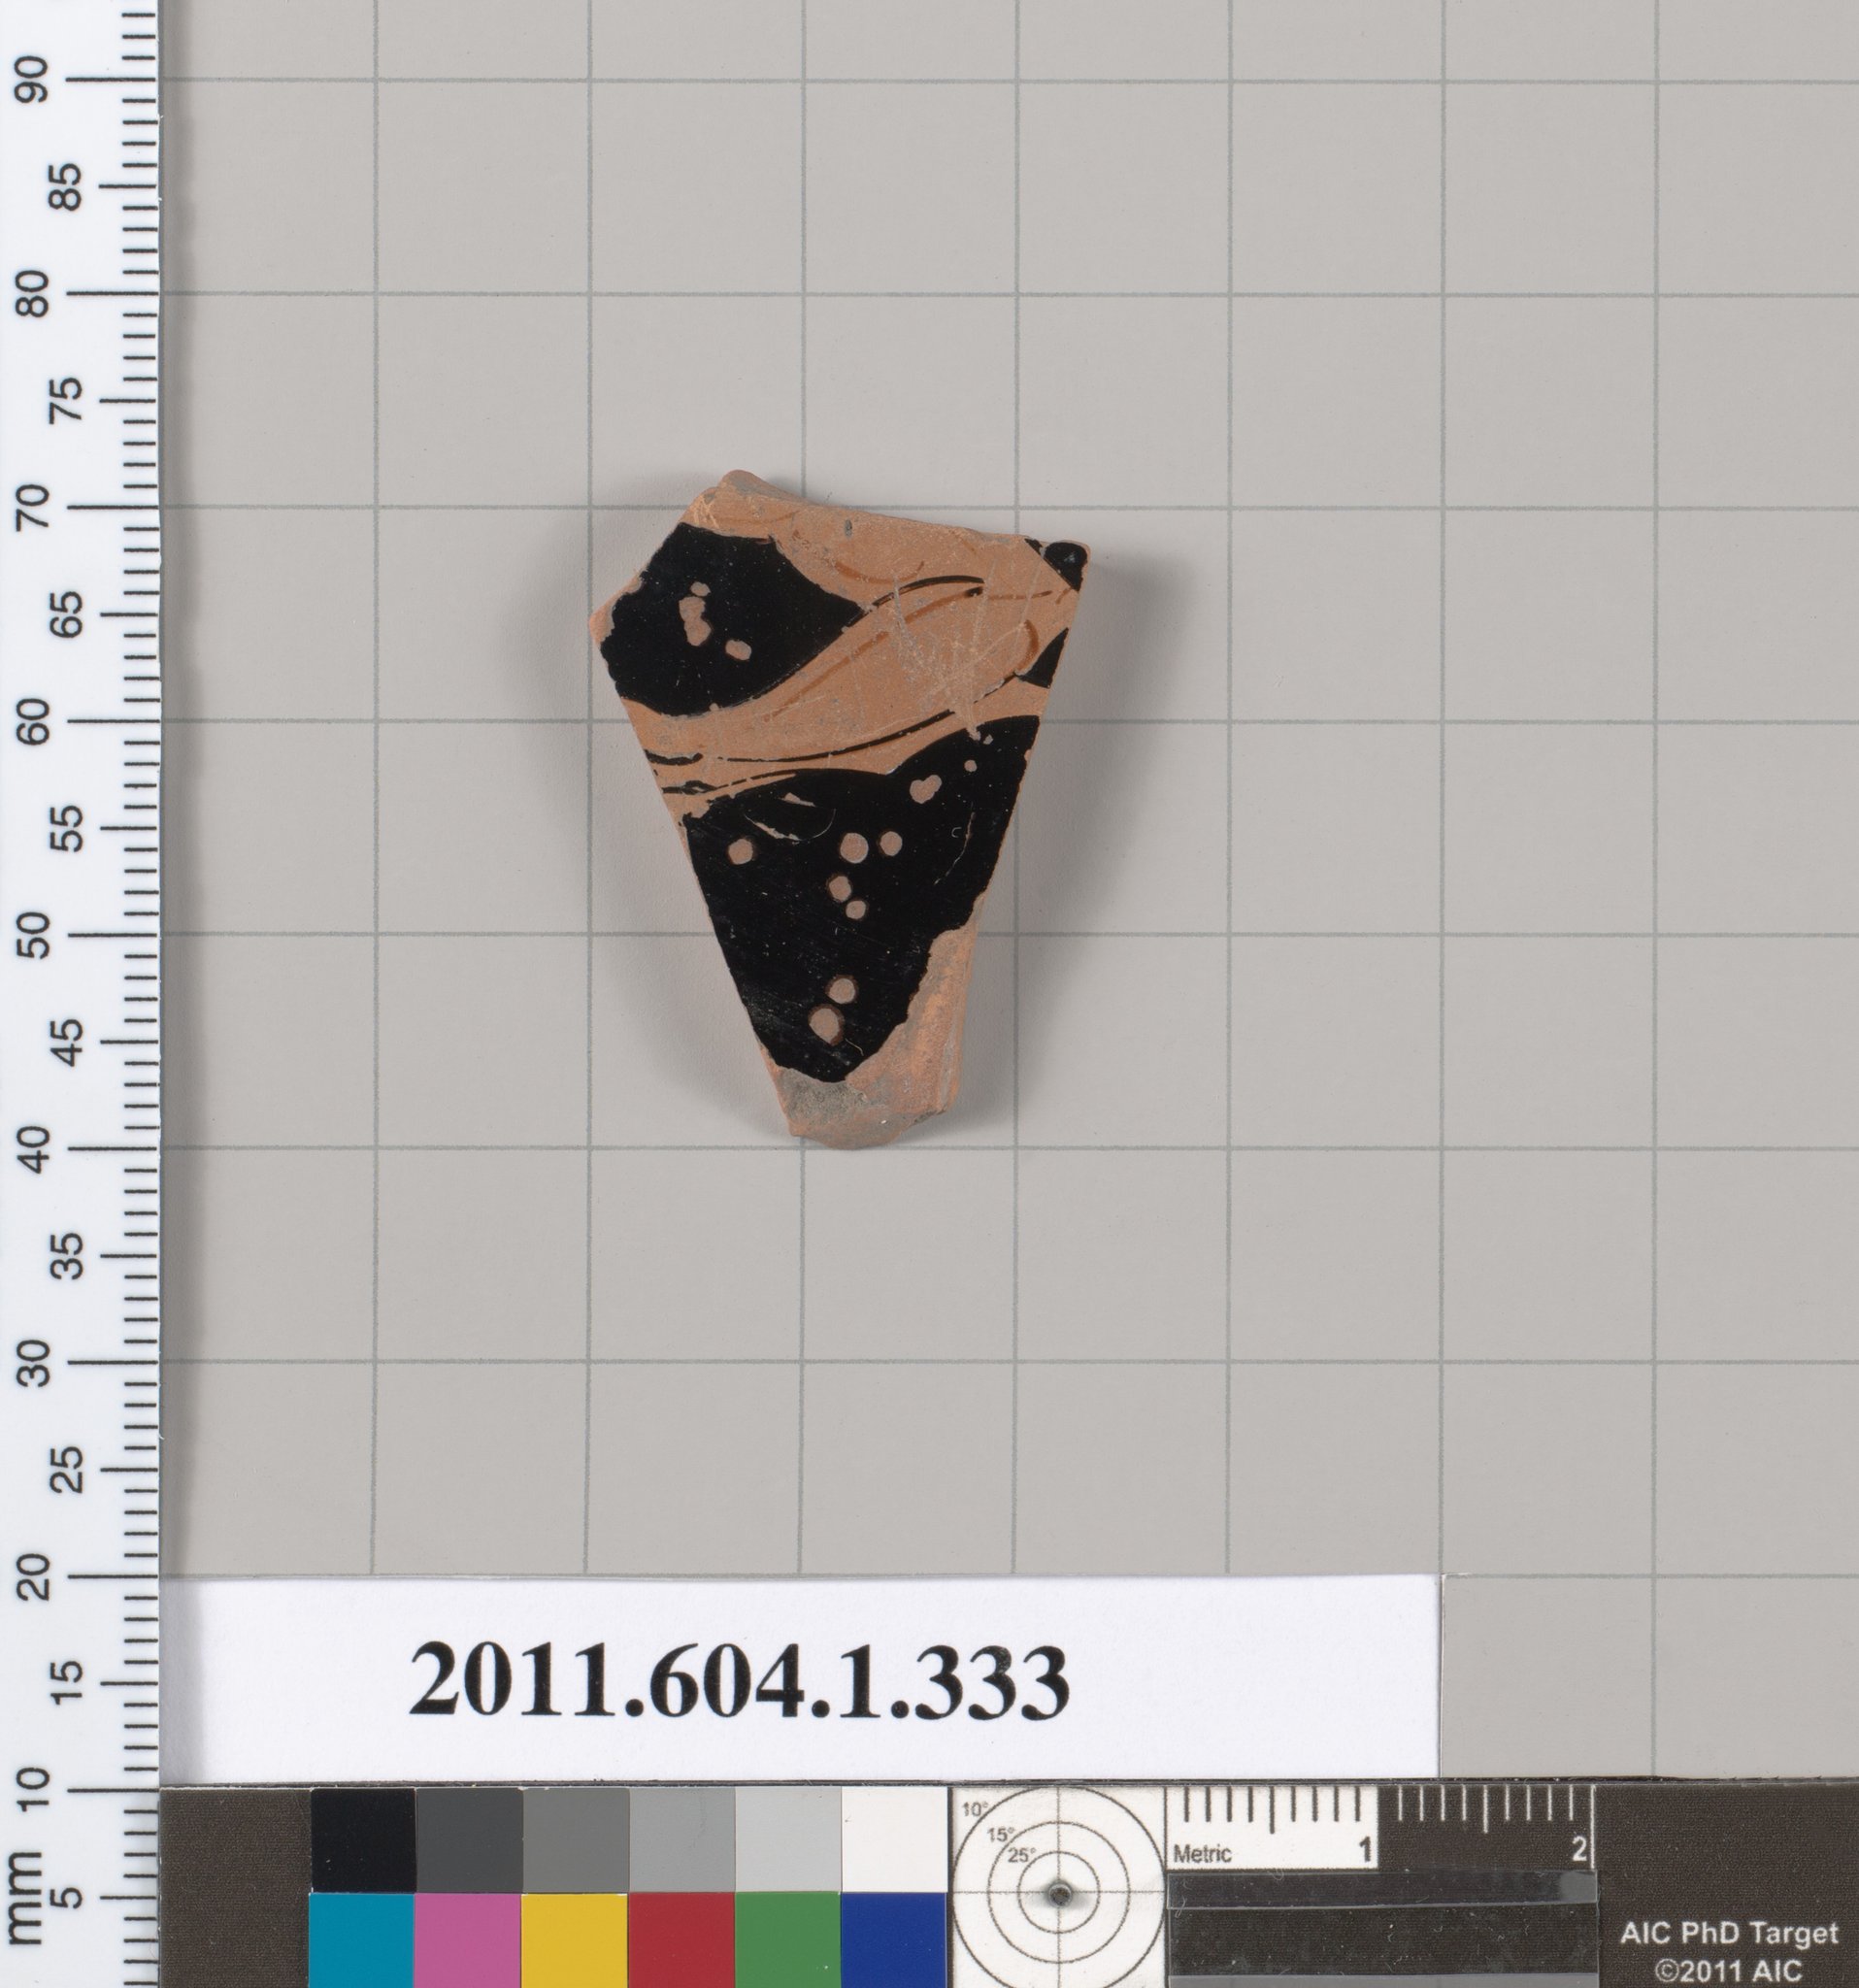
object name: kylix fragment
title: Terracotta fragment of a kylix (drinking cup)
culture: greek, attic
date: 475-451 BCE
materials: terracotta